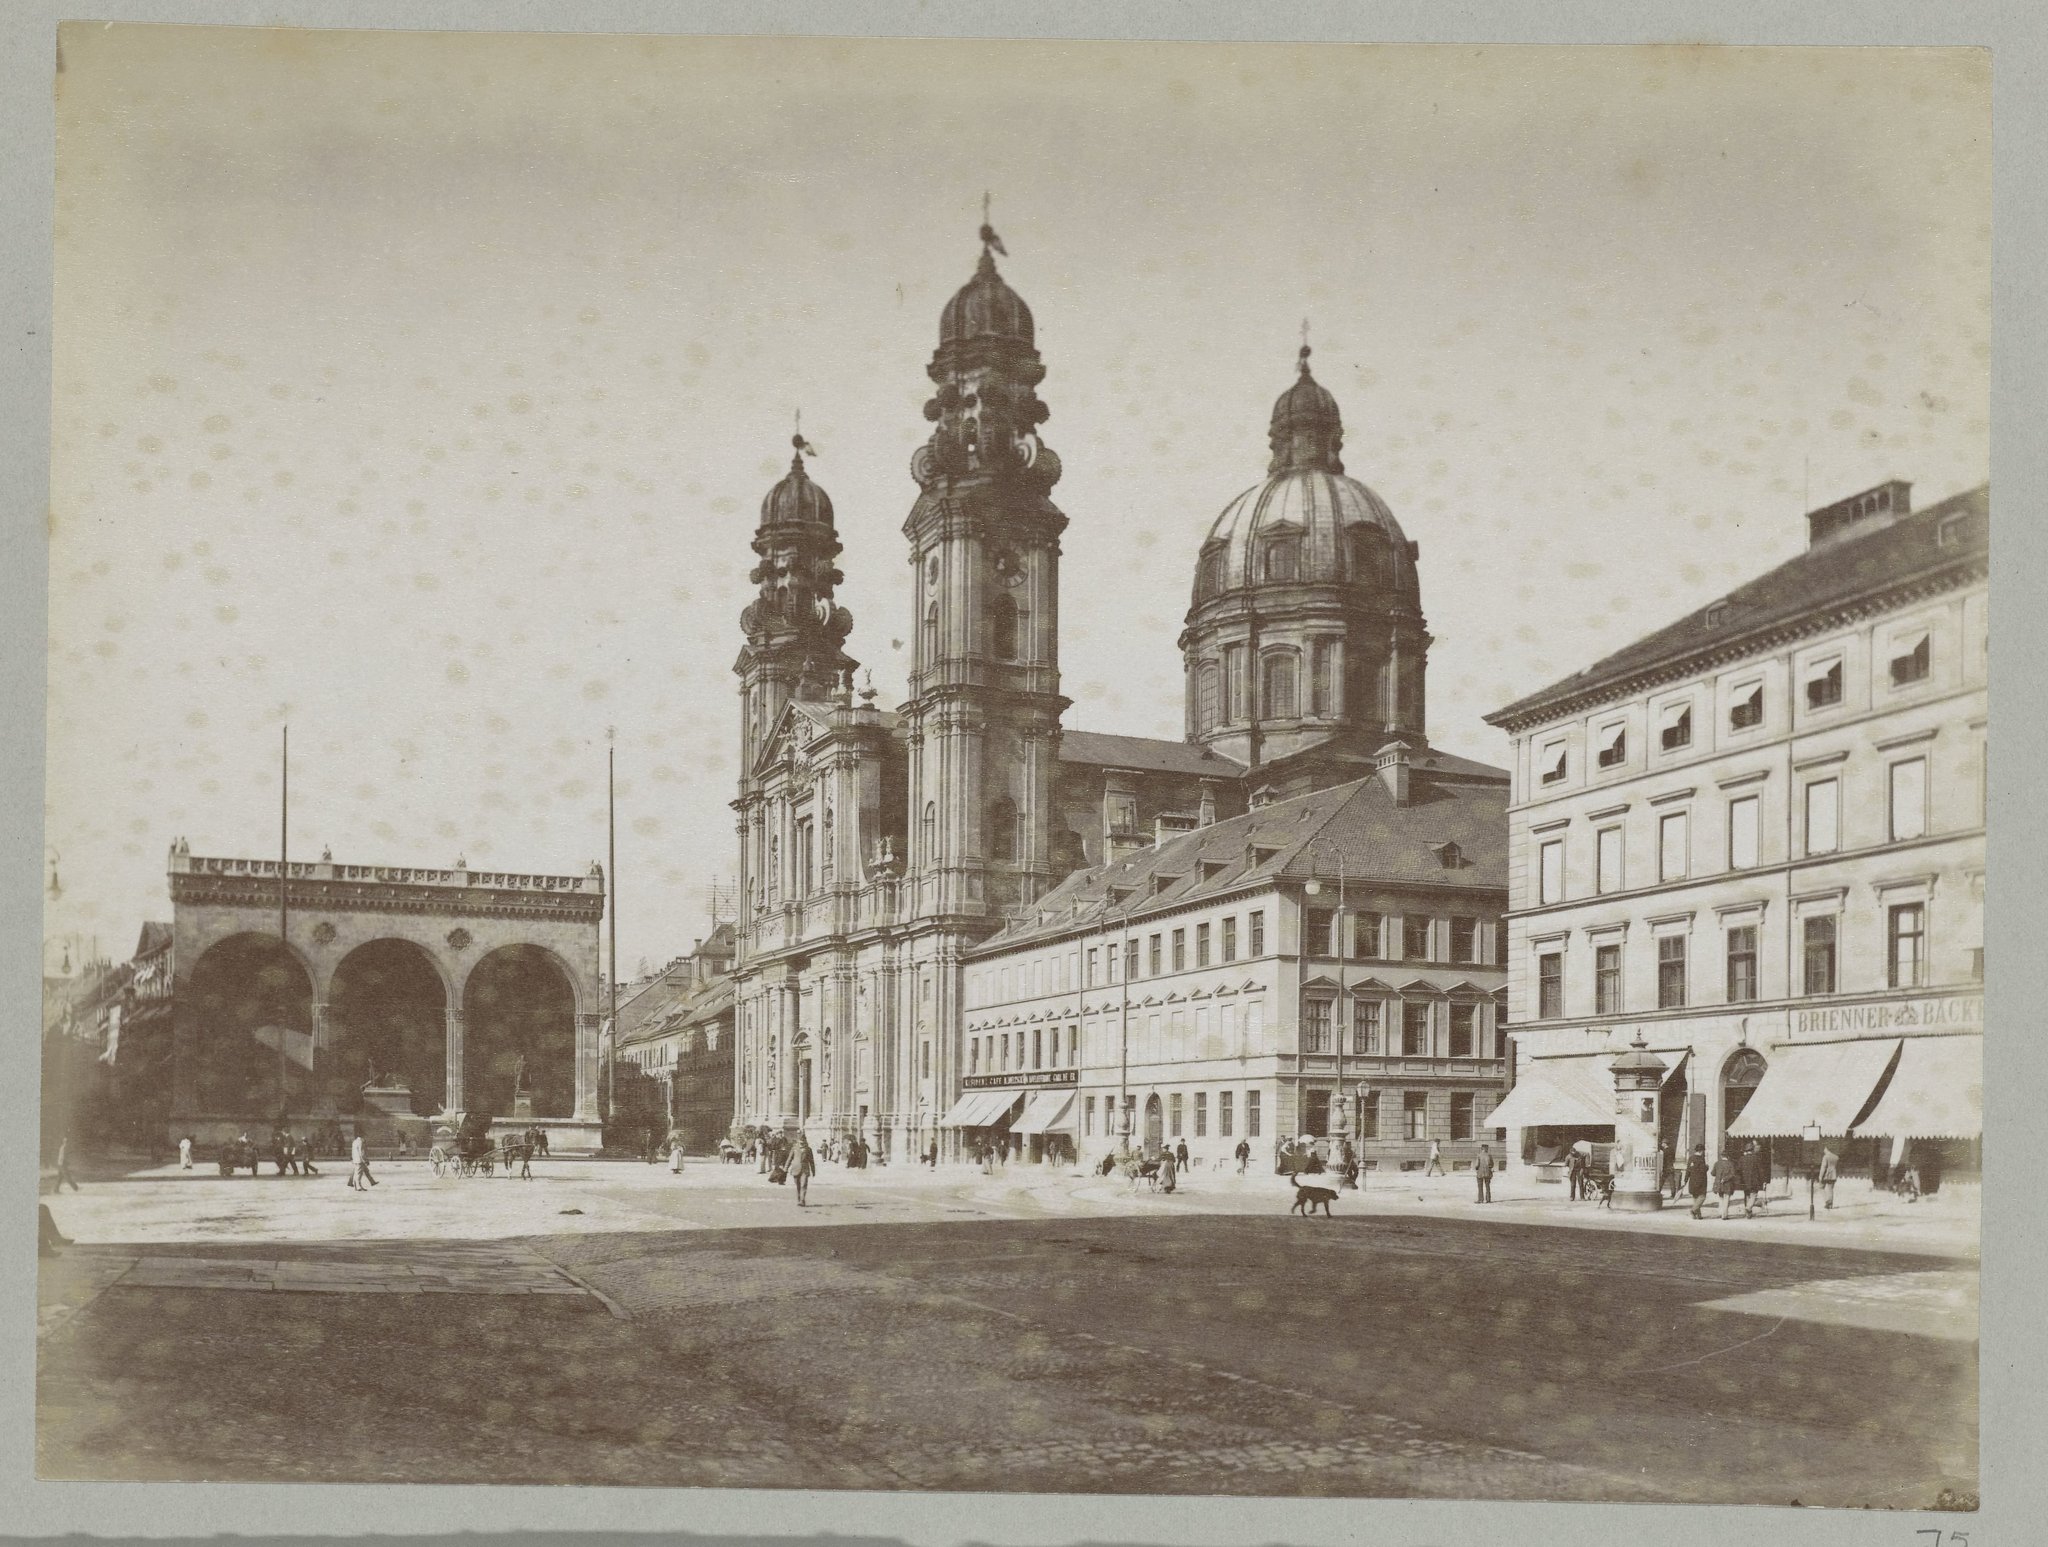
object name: photograph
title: Plein met de Sint Lukas kerk in München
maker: Anonymous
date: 1893-1903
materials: cardboard, photographic support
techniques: albumen print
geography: munich